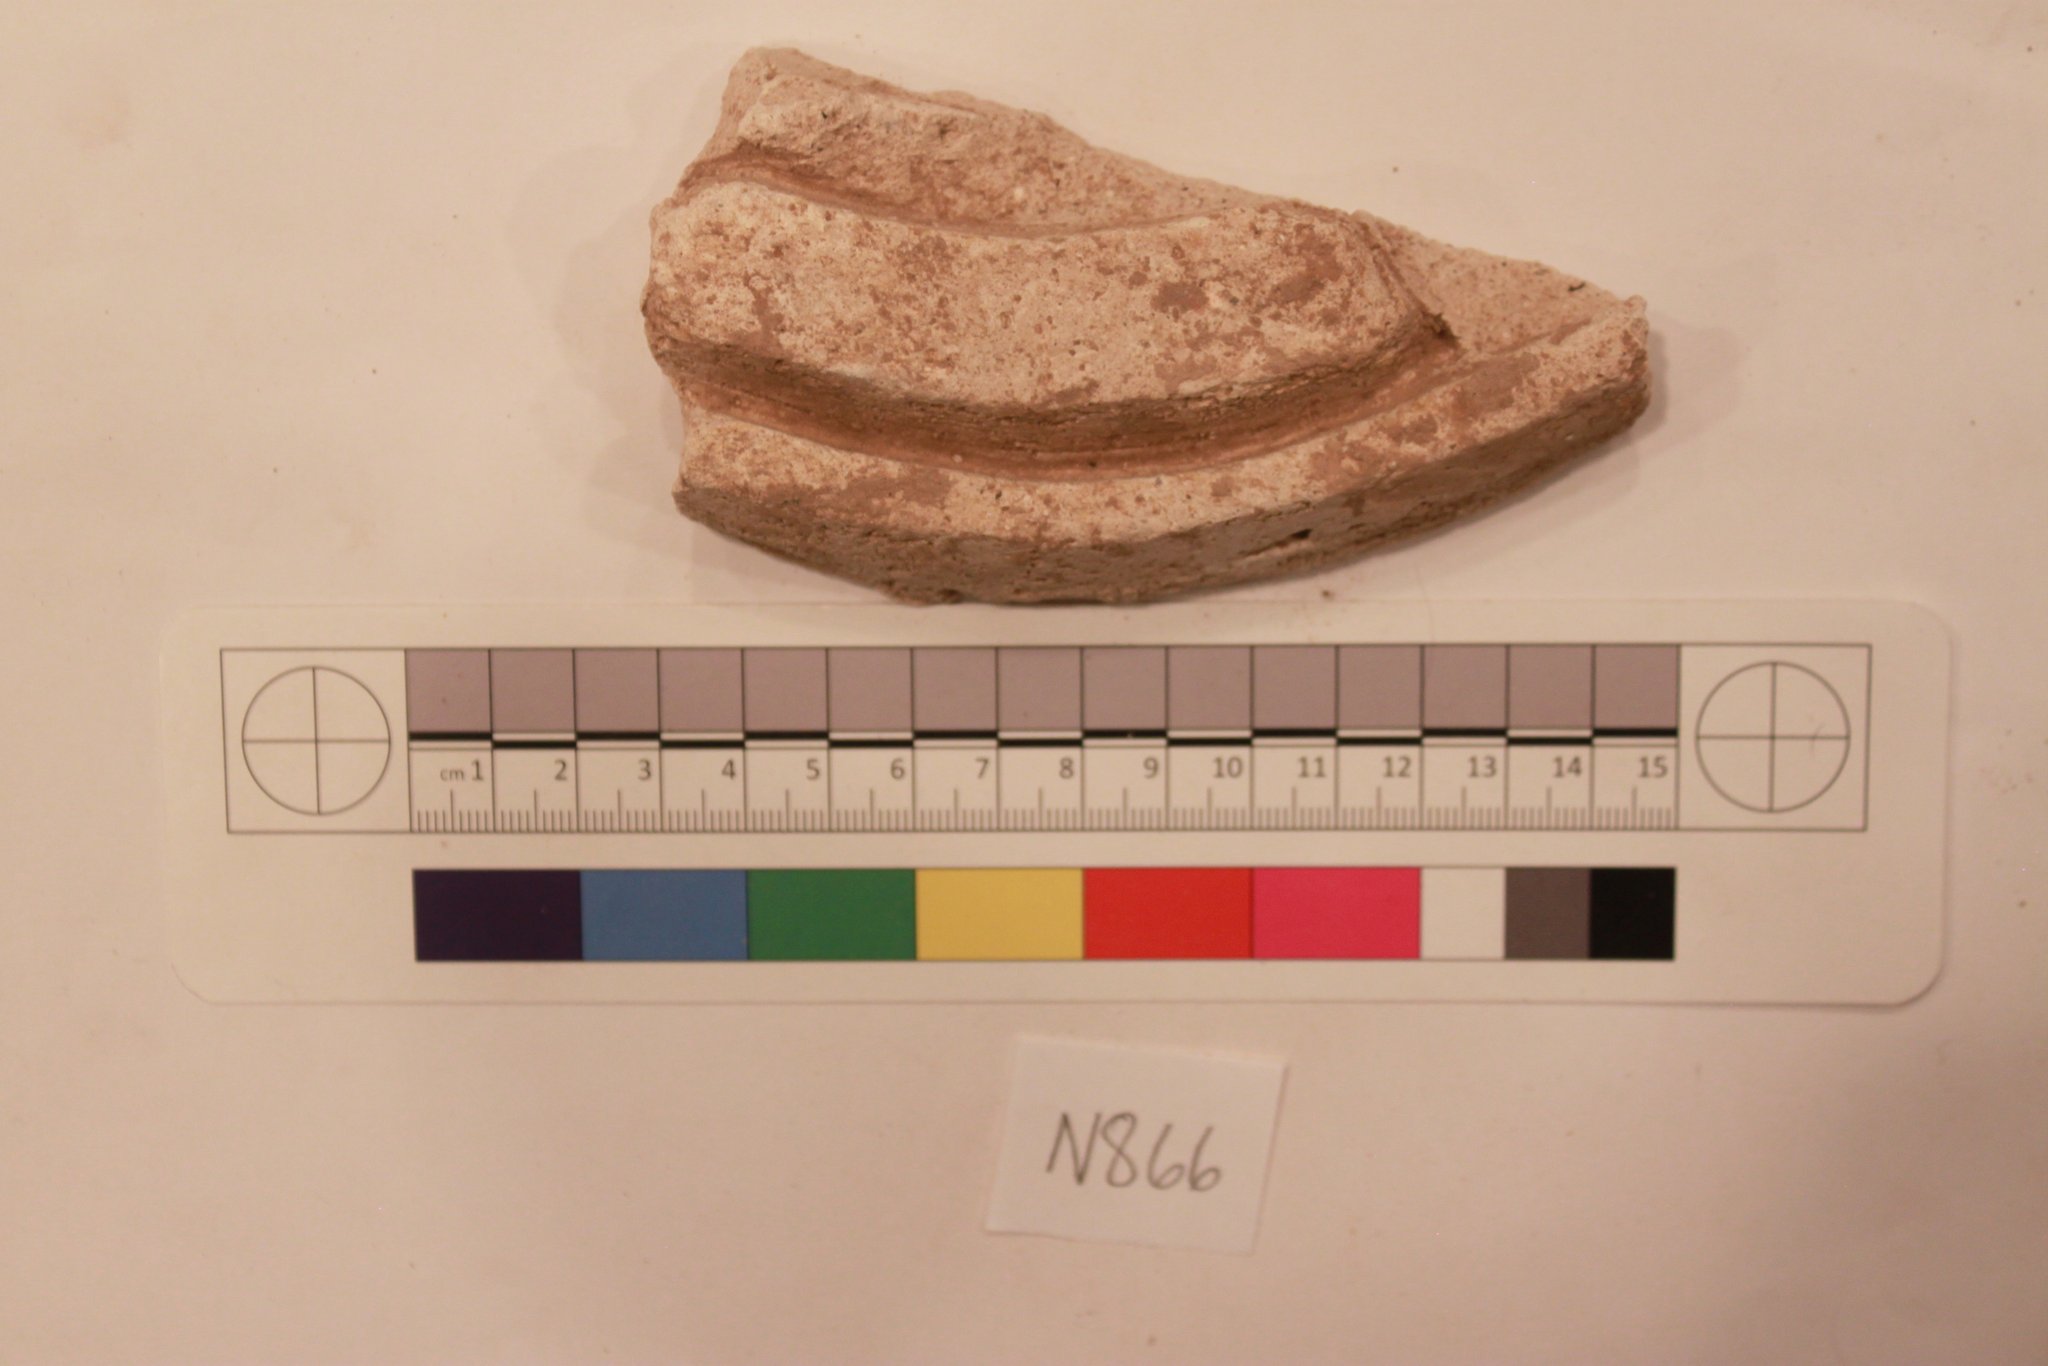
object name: fragment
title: Stucco Fragment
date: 701-1200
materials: plaster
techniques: carving, painting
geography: iran